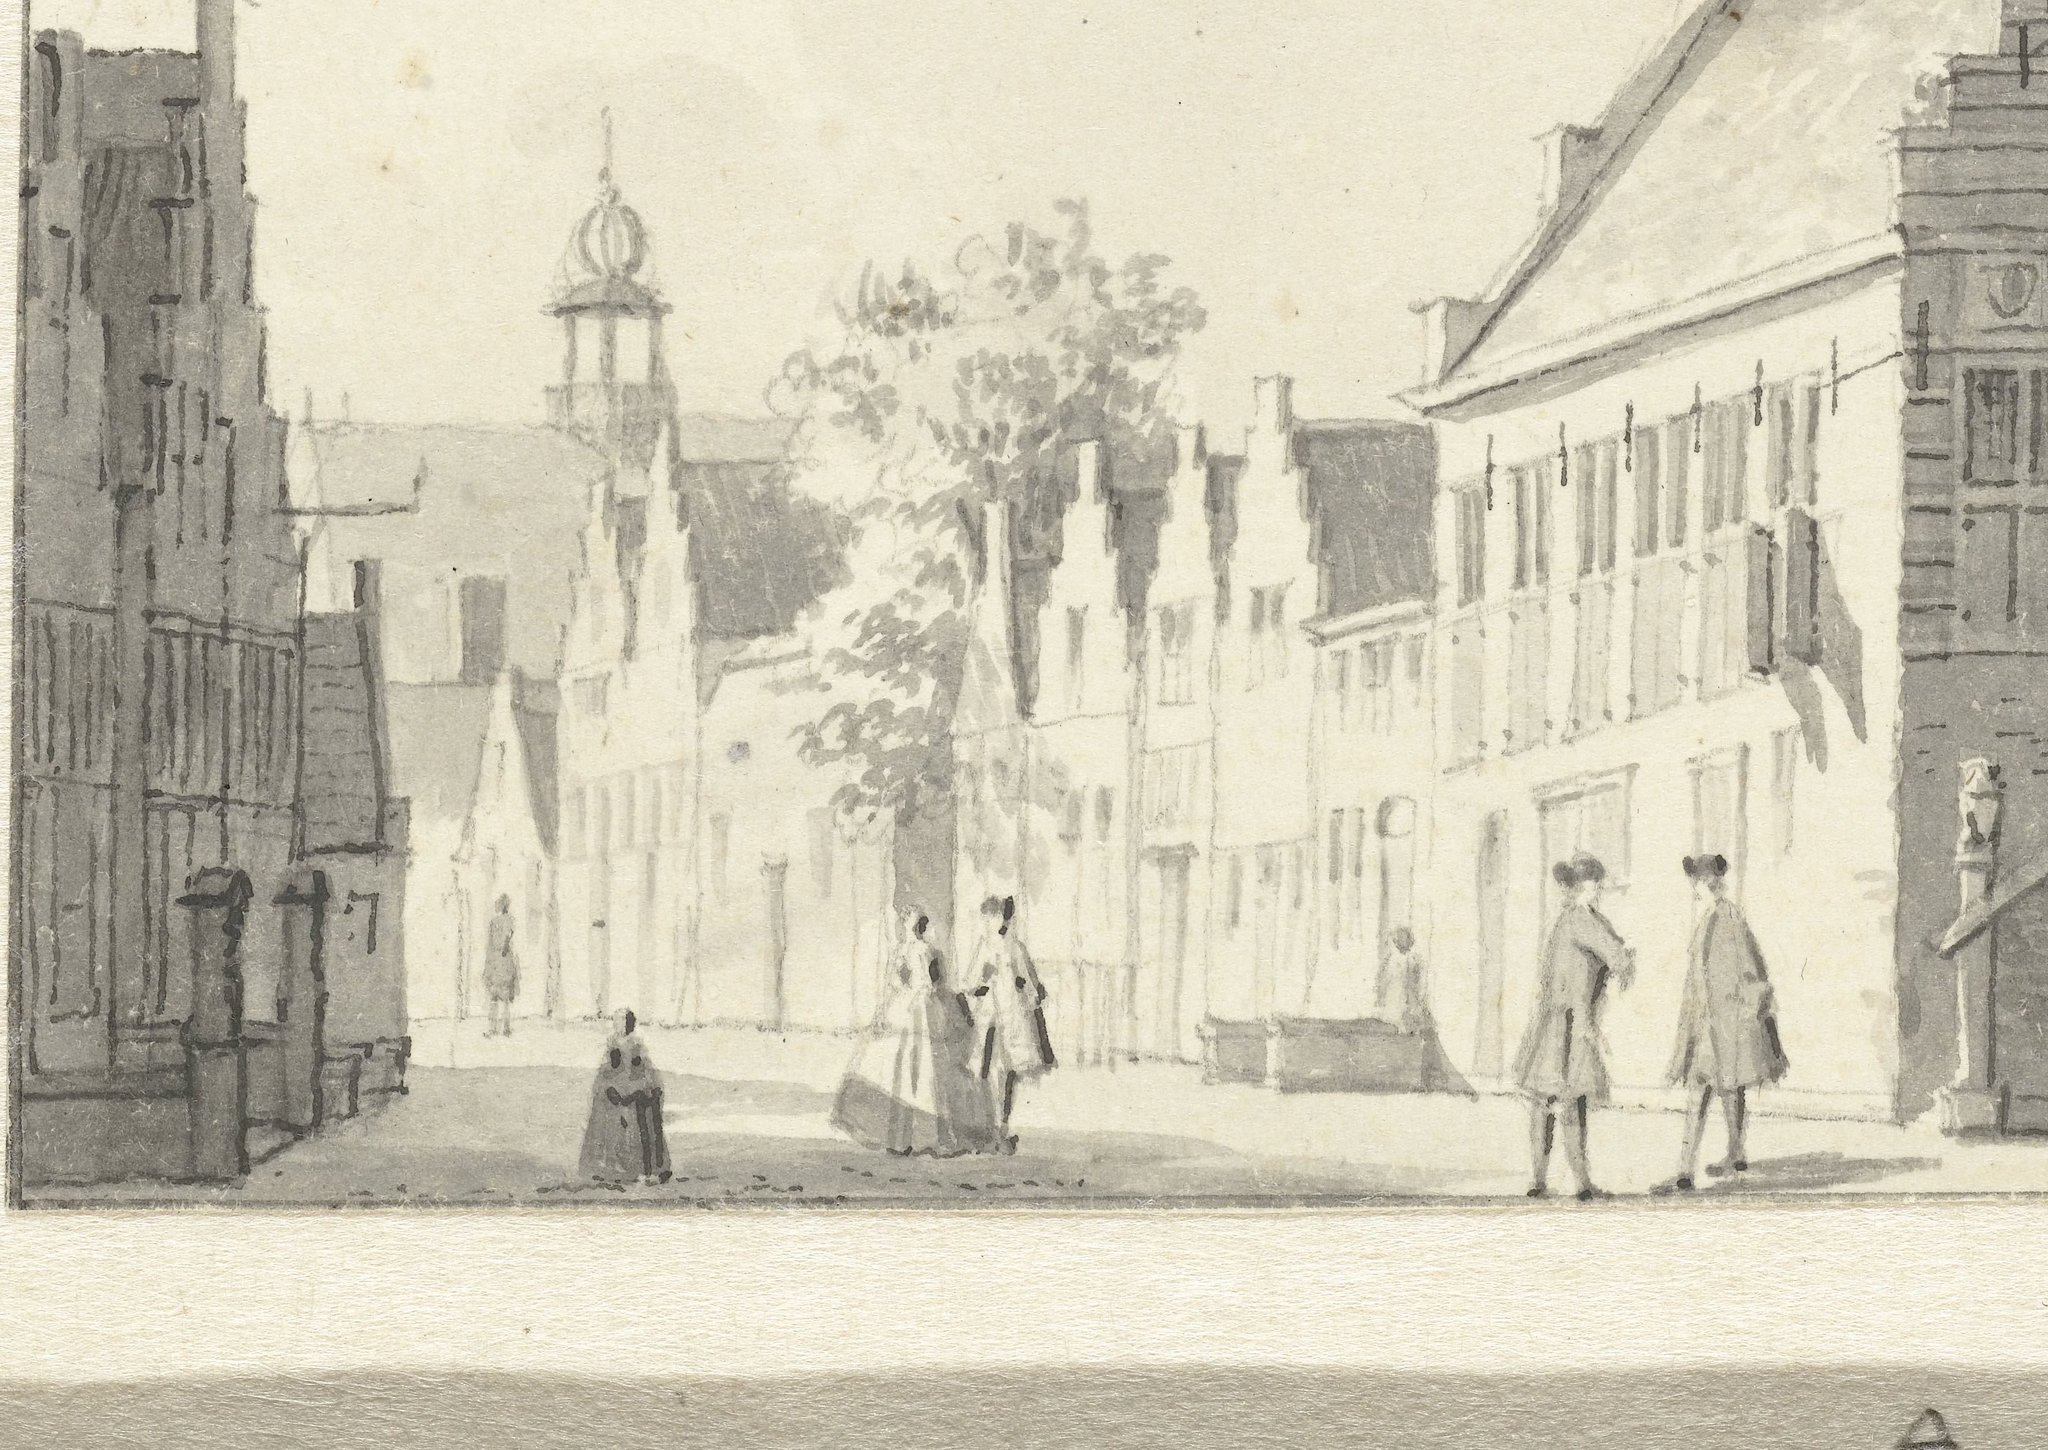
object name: drawing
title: Het stadhuis te Oudewater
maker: hendrik de winter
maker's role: draughtsman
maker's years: 1717-1790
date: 1745-1750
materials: ink, paper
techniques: brush, pen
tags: townhall, street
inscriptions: inscription: ‘H De winter del ad viv:1745 D'Nuwe Porrt te Oudewaatter’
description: Ontwerptekening voor de prent eerst gebruikt in: Het verheerlykt Nederland of kabinet van hedendaagsche gezigten van steden, dorpen (…). 9 delen. Amsterdam: Isaak Tirion en weduwe Isaak Tirion, 1745-1774, dl. 3 (1750), ill. 257.